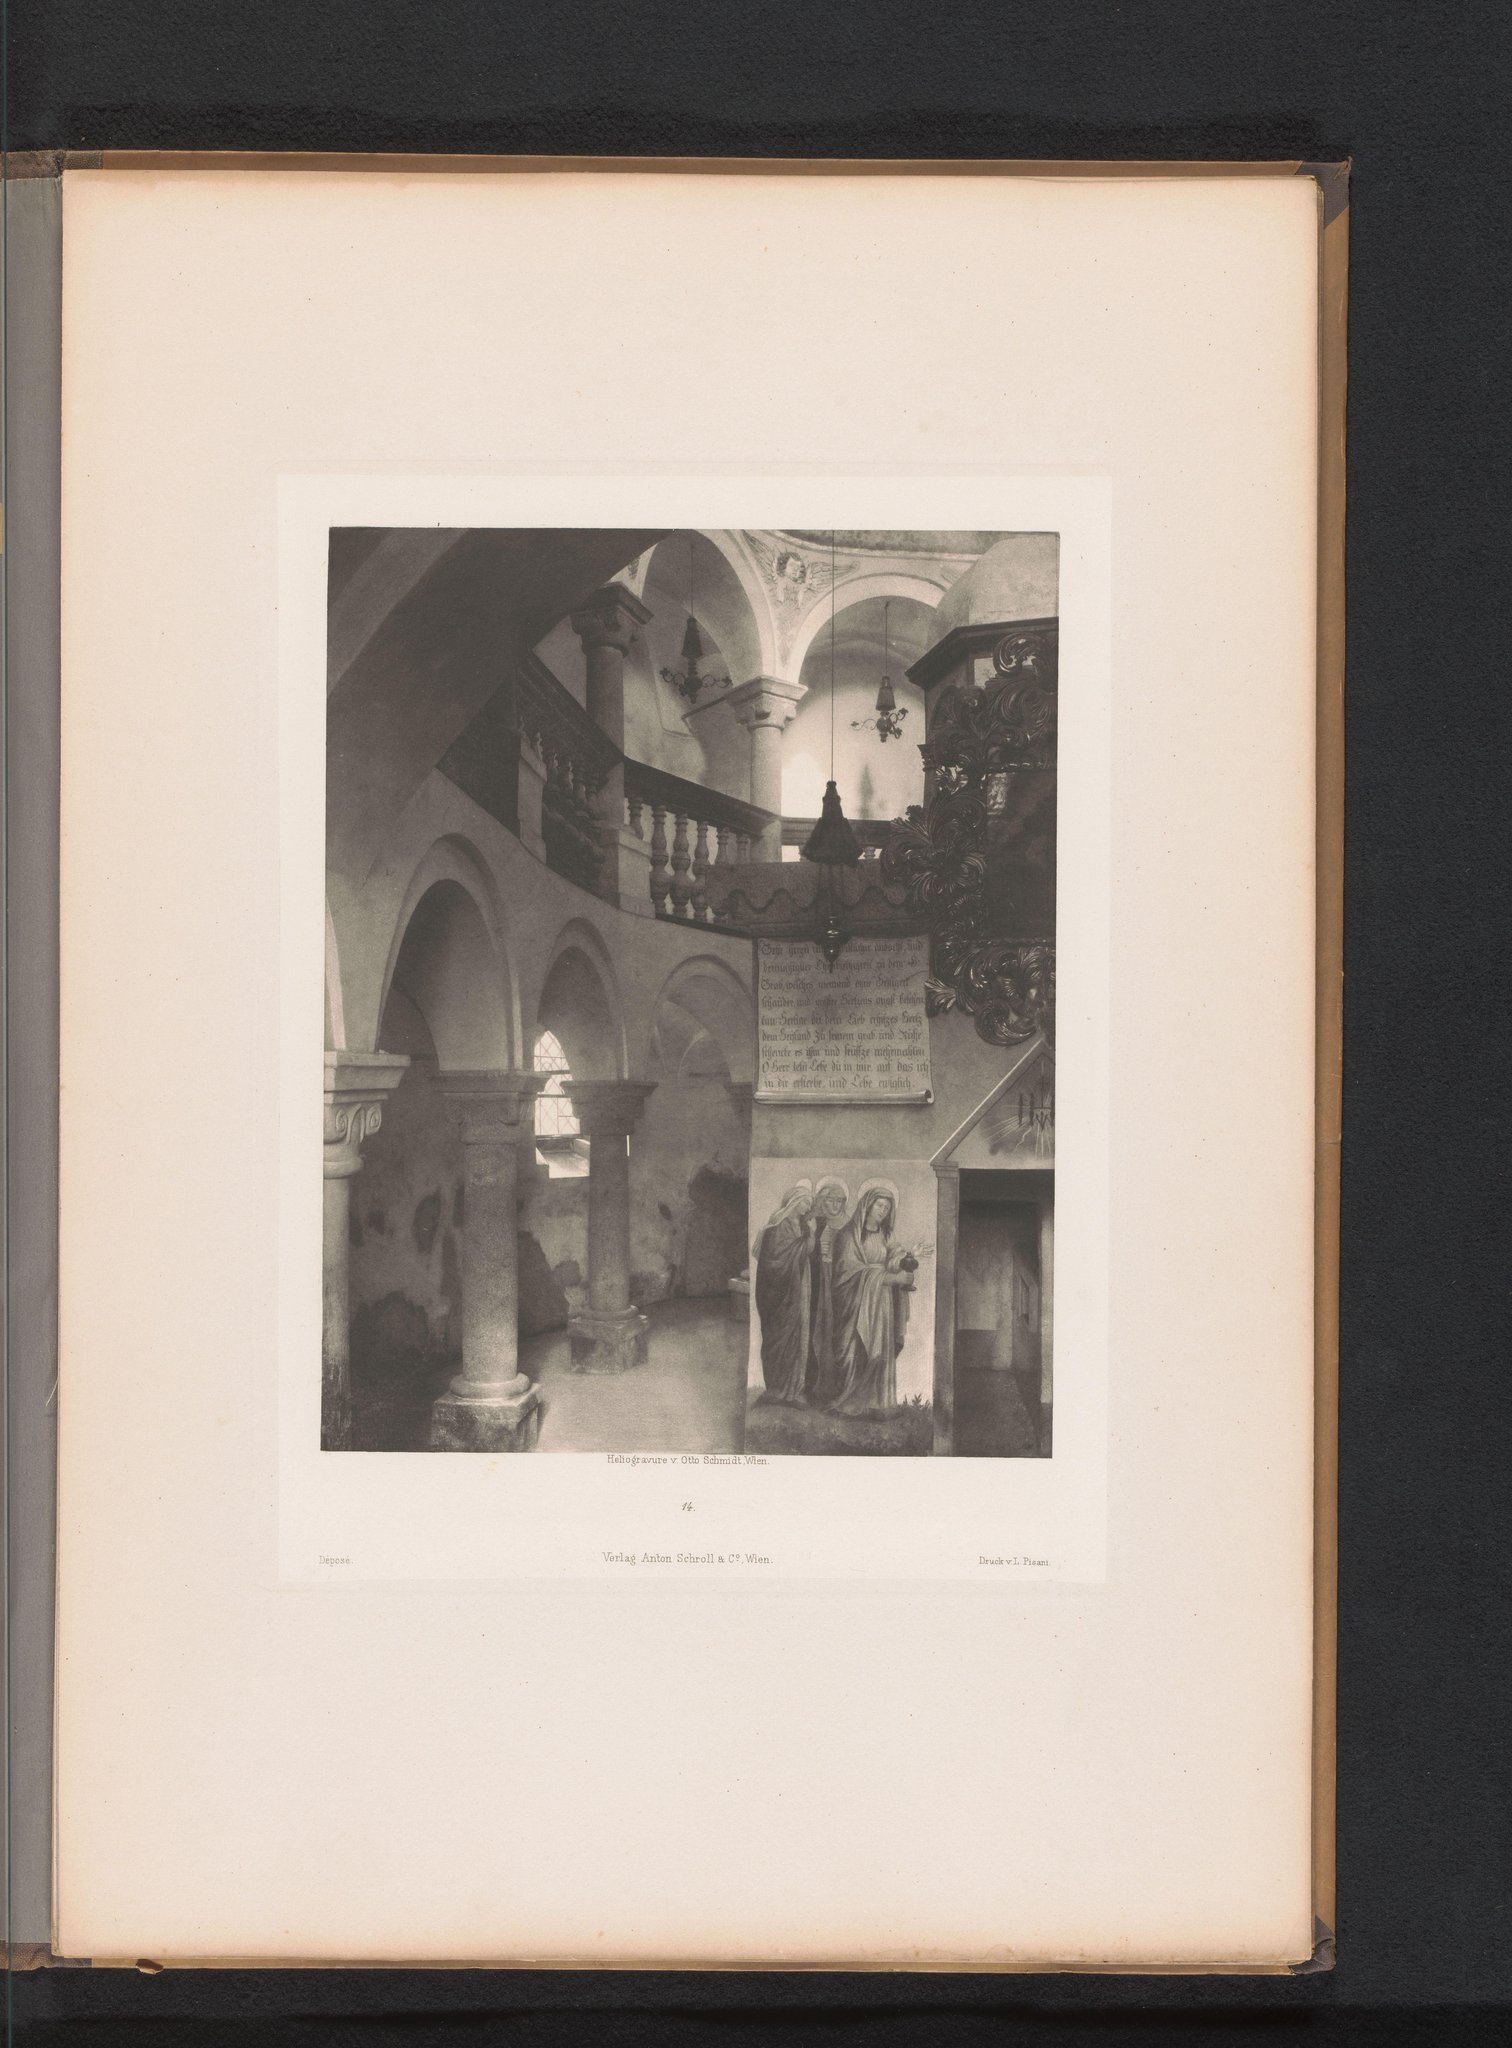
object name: photomechanical print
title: Gezicht op het interieur van de grafkapel in San Candido, Italië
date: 1886-1891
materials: paper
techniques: photoaquatint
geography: vienna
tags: parts of church exterior and annexes: chapel - qq - small church, chapel, grave, tomb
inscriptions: number: ‘14.’, inscription: ‘Déposé.’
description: Deze prent maakt deel uit van een omslag met dertig prenten en drie tekstbladen.